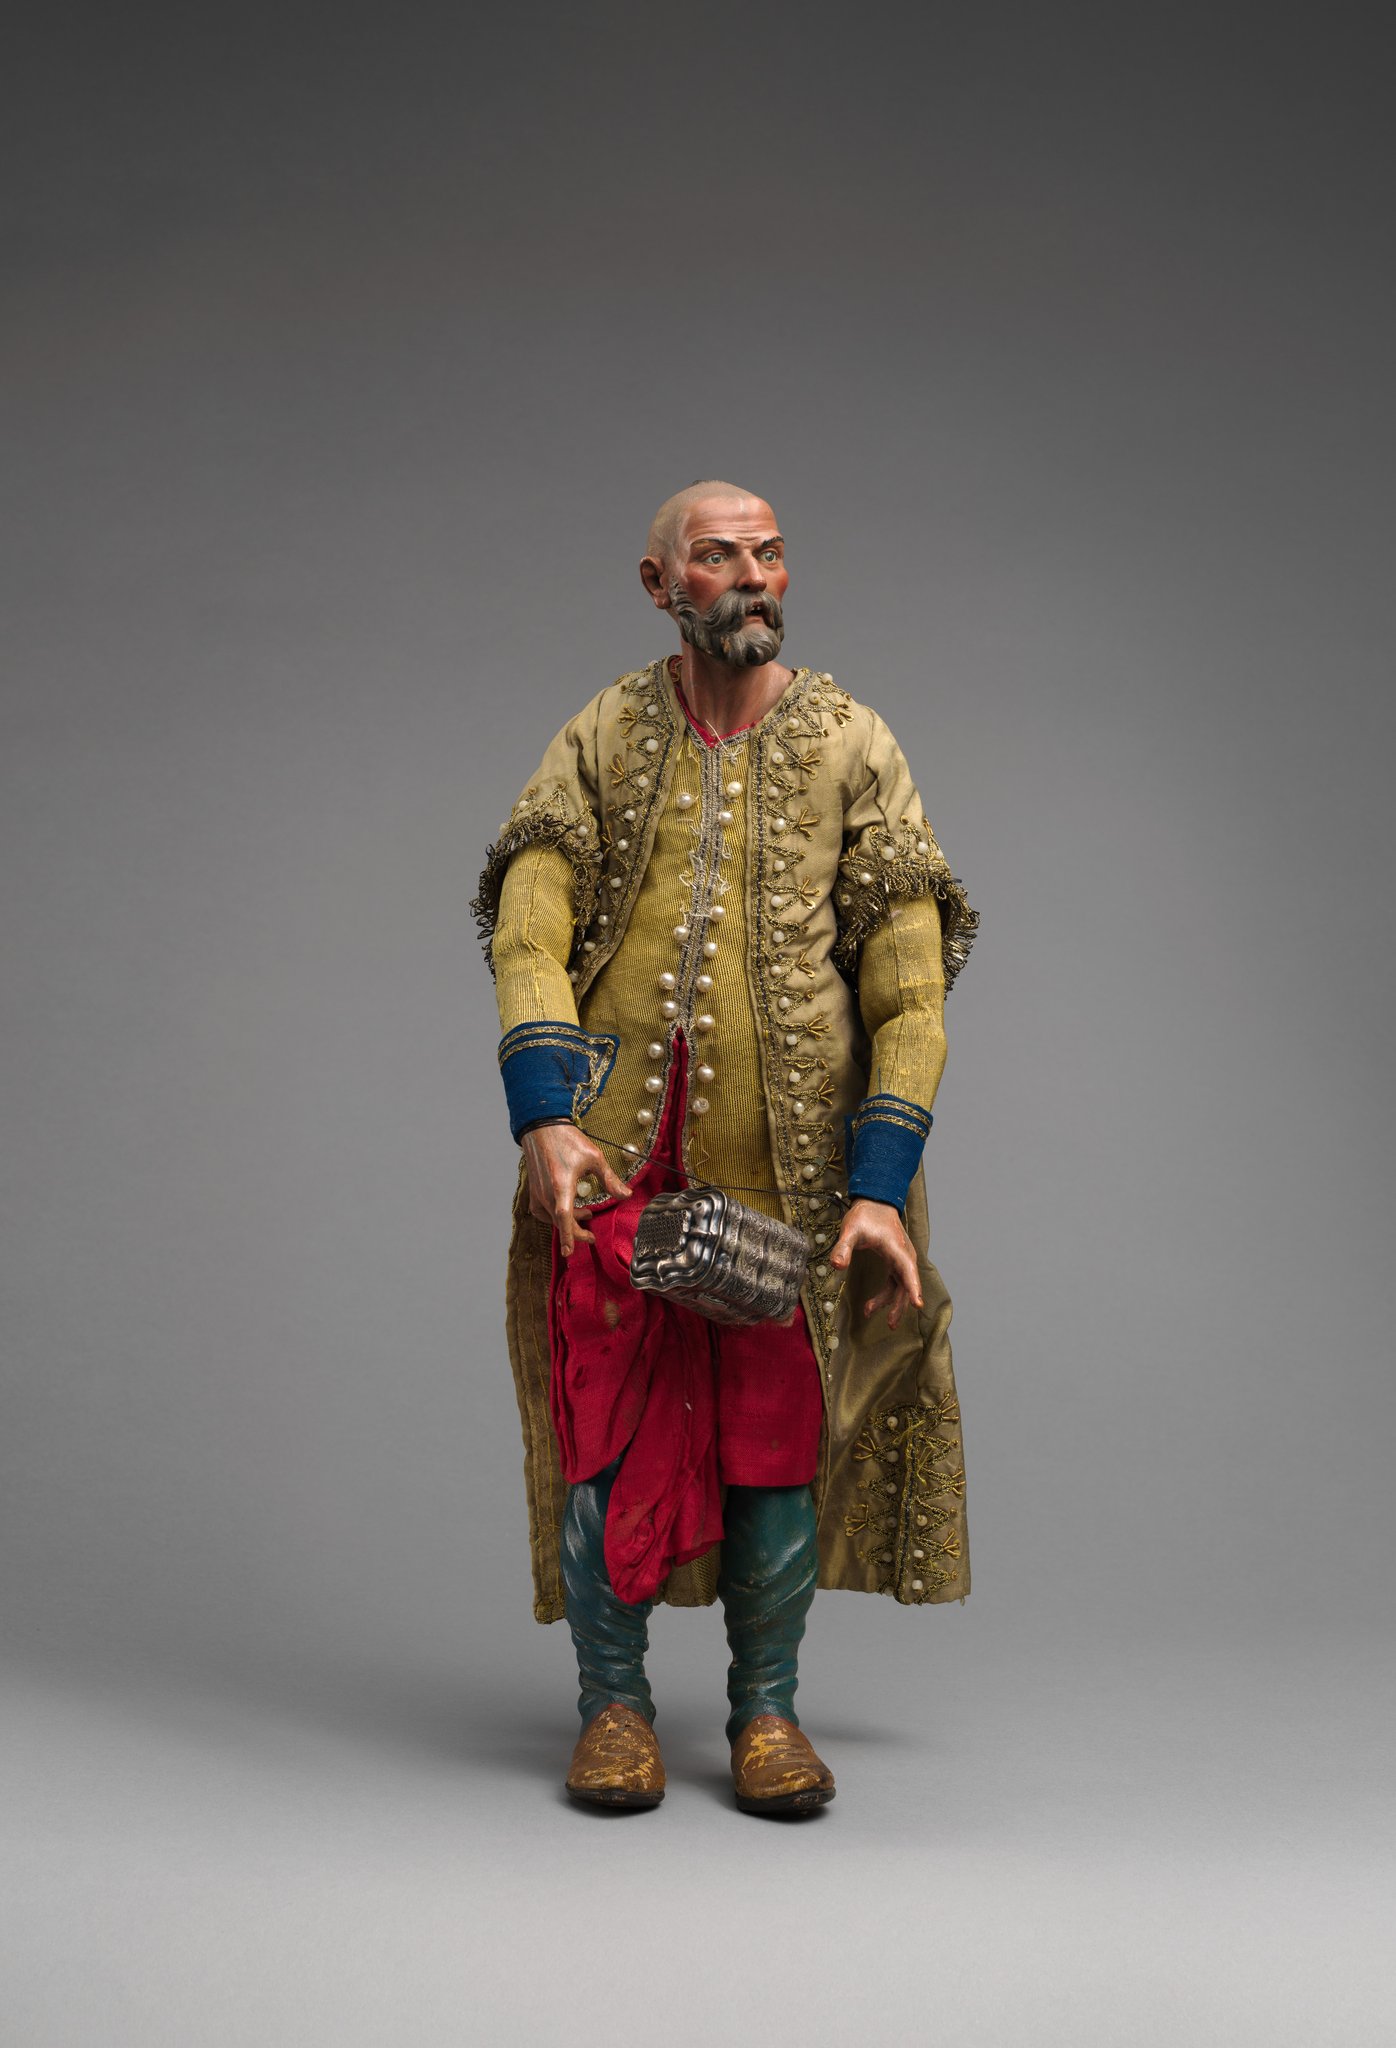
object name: crèche figure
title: King in gold beaded coat, yellow vest, red pants with silver chest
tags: kings,men